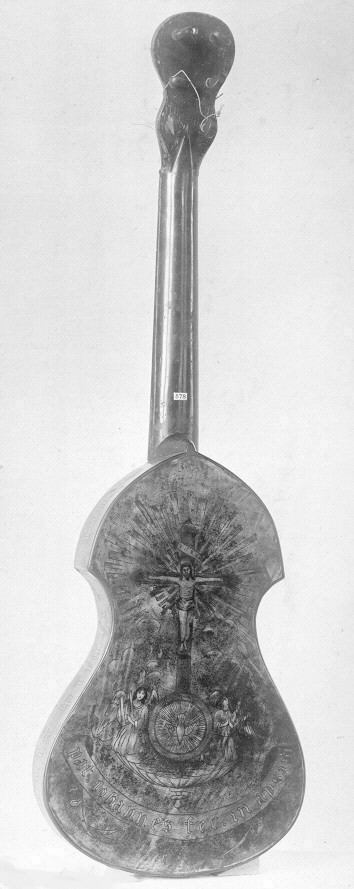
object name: guitar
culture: tyrolean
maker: "father john" of aspam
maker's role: maker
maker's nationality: tyrolean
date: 1688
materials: ivory, wood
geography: austria